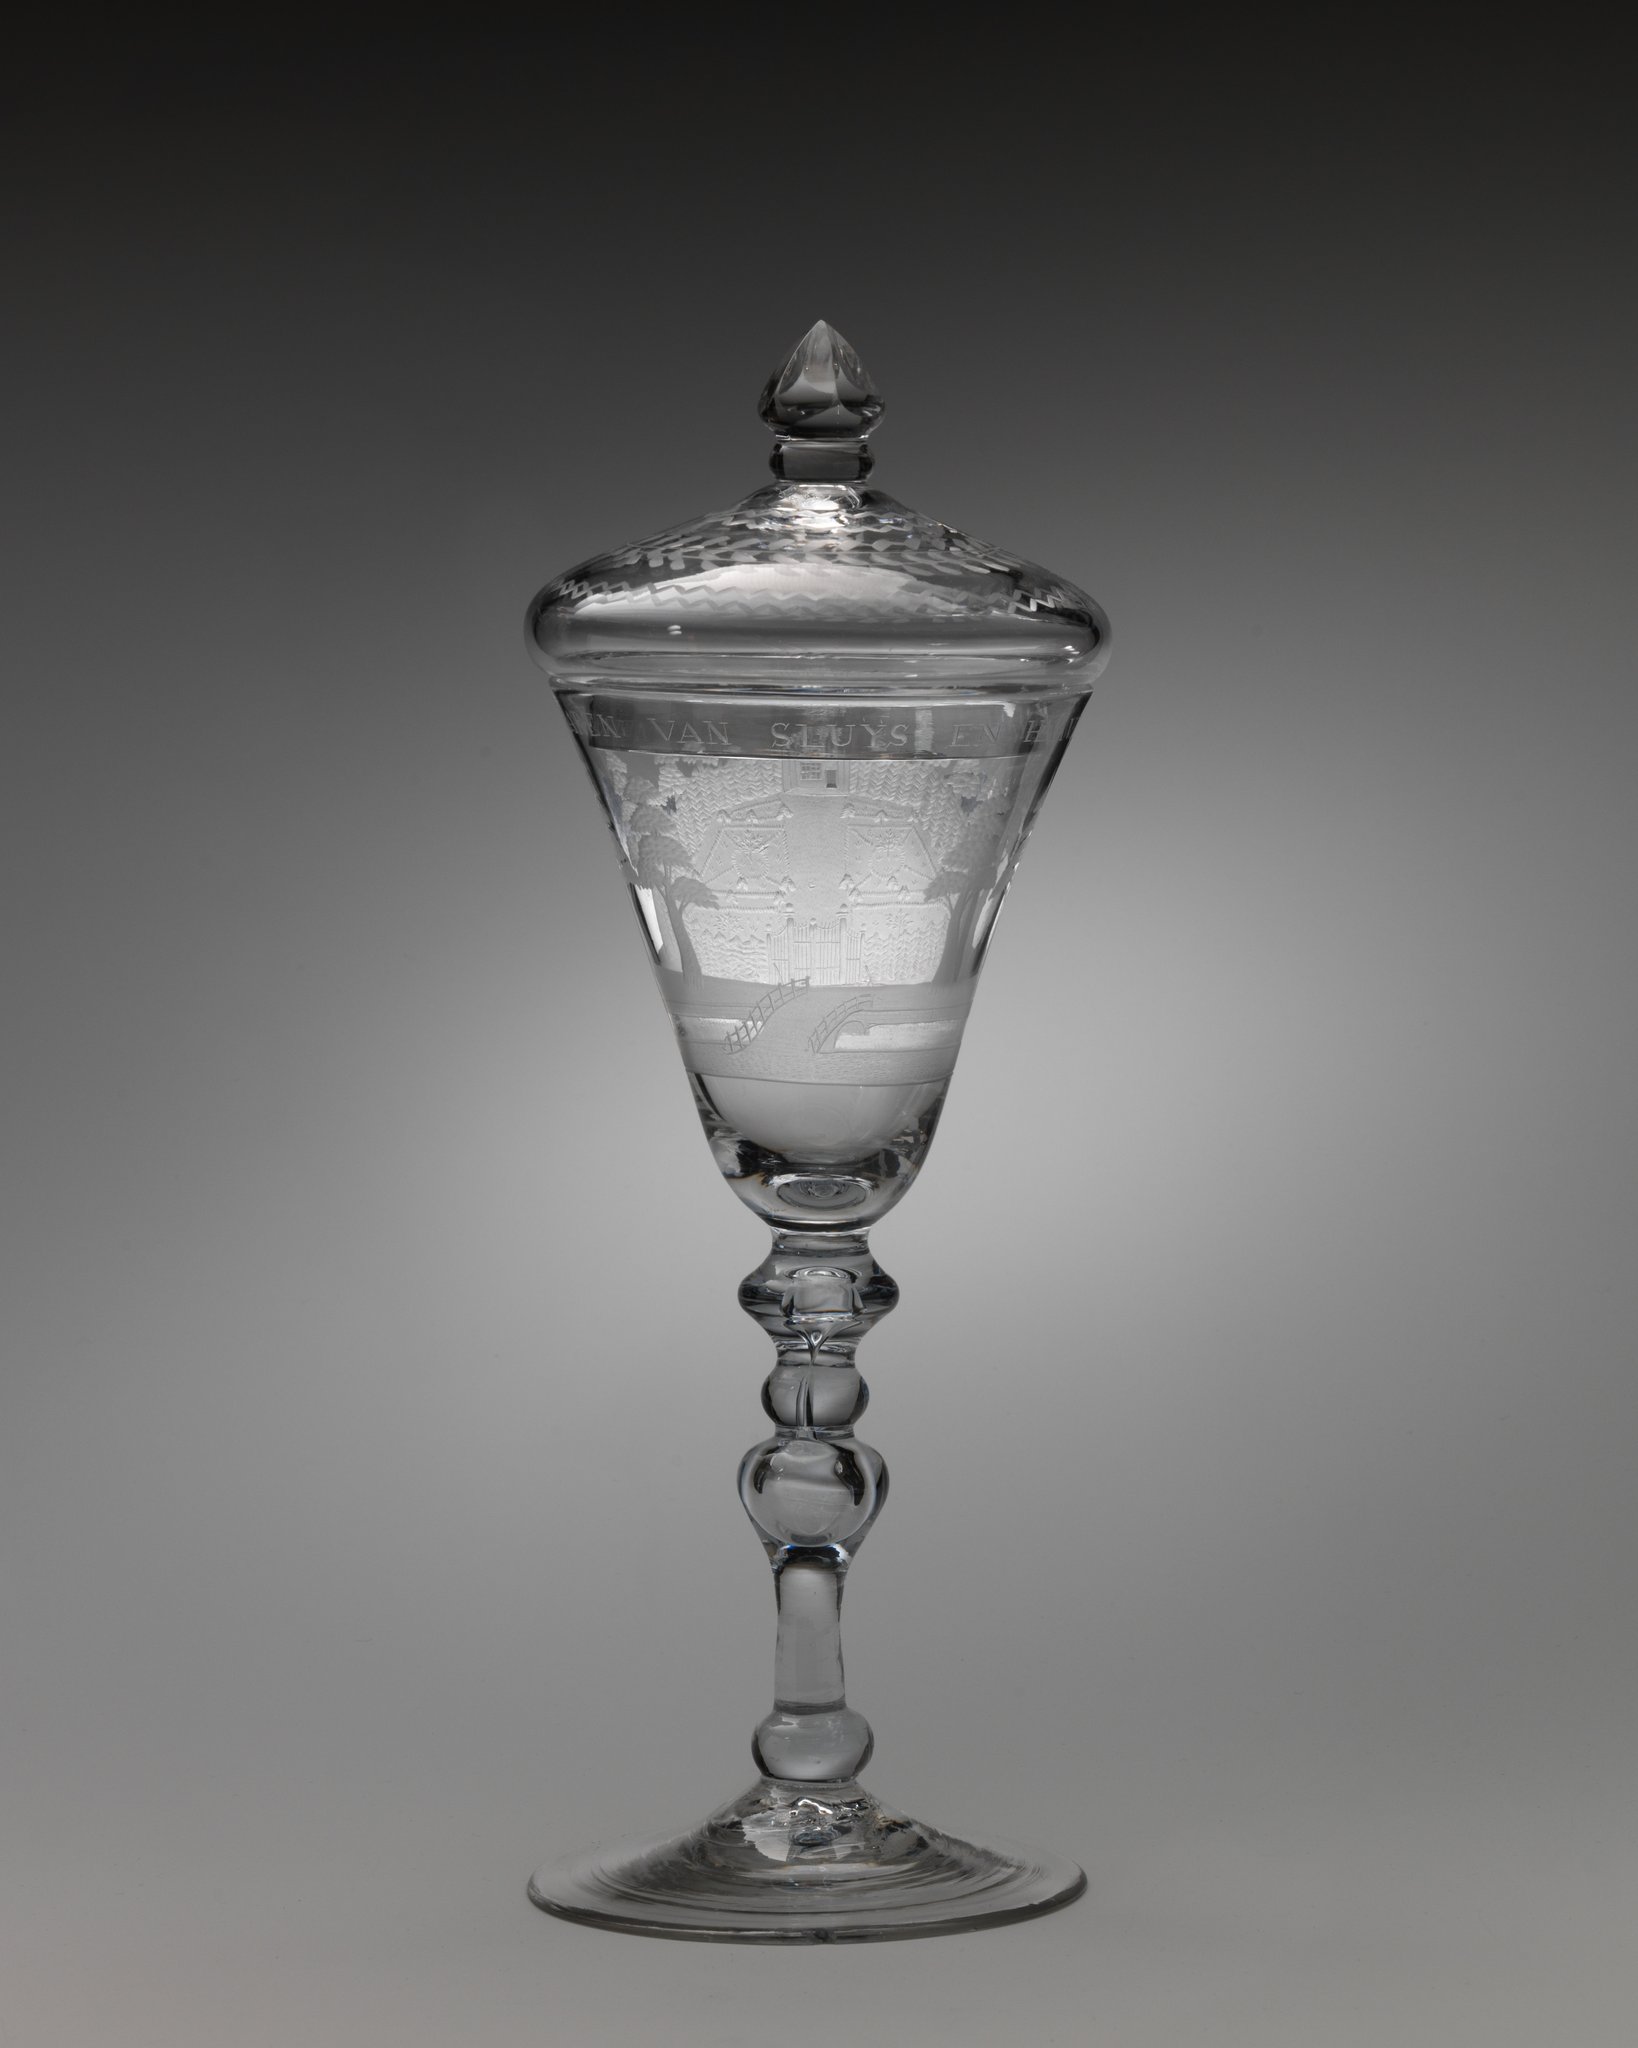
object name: wineglass with cover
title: Toasting wineglass with cover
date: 1740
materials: glass